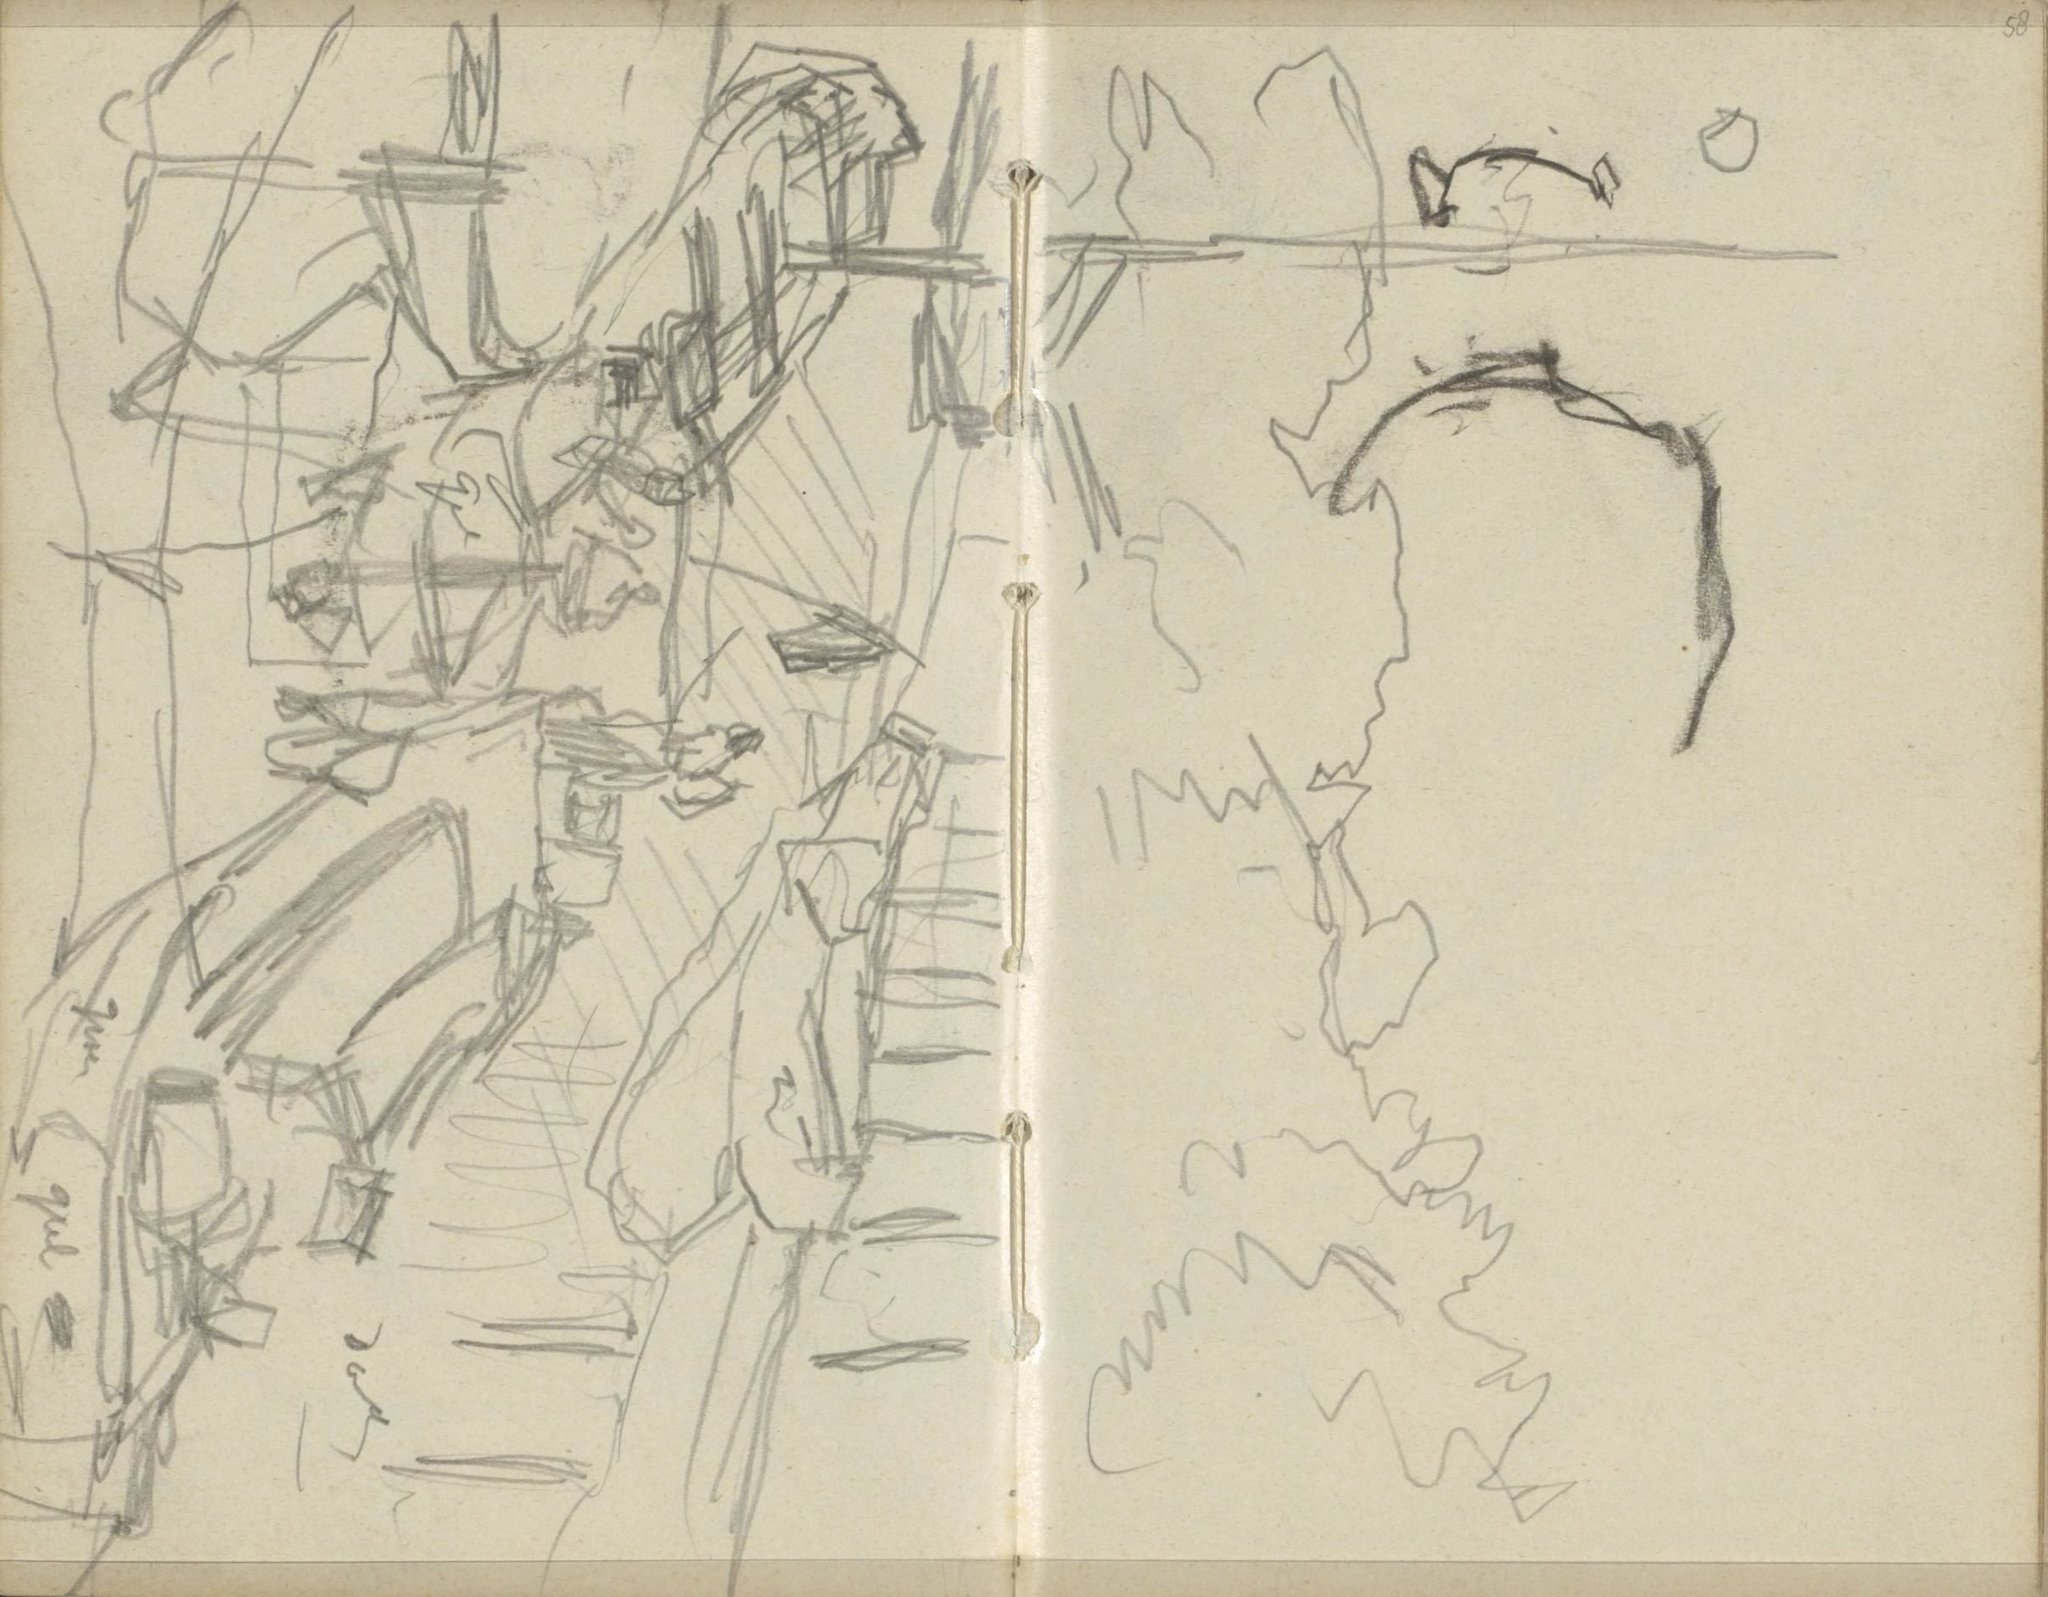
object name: sketchbook leaf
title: Gezicht op een gracht in Amsterdam met boten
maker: george hendrik breitner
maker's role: draughtsman, painter, print maker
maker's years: 1857-1923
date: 1910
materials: chalk, paper, pencil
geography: amsterdam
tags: ships (in general), canals, waters (in city), horse, amsterdam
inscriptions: kleurnotitie, handgeschreven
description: Ook een studie van een paard, van achteren gezien. Pagina 57 en pagina 58 uit een schetsboek met 45 bladen.